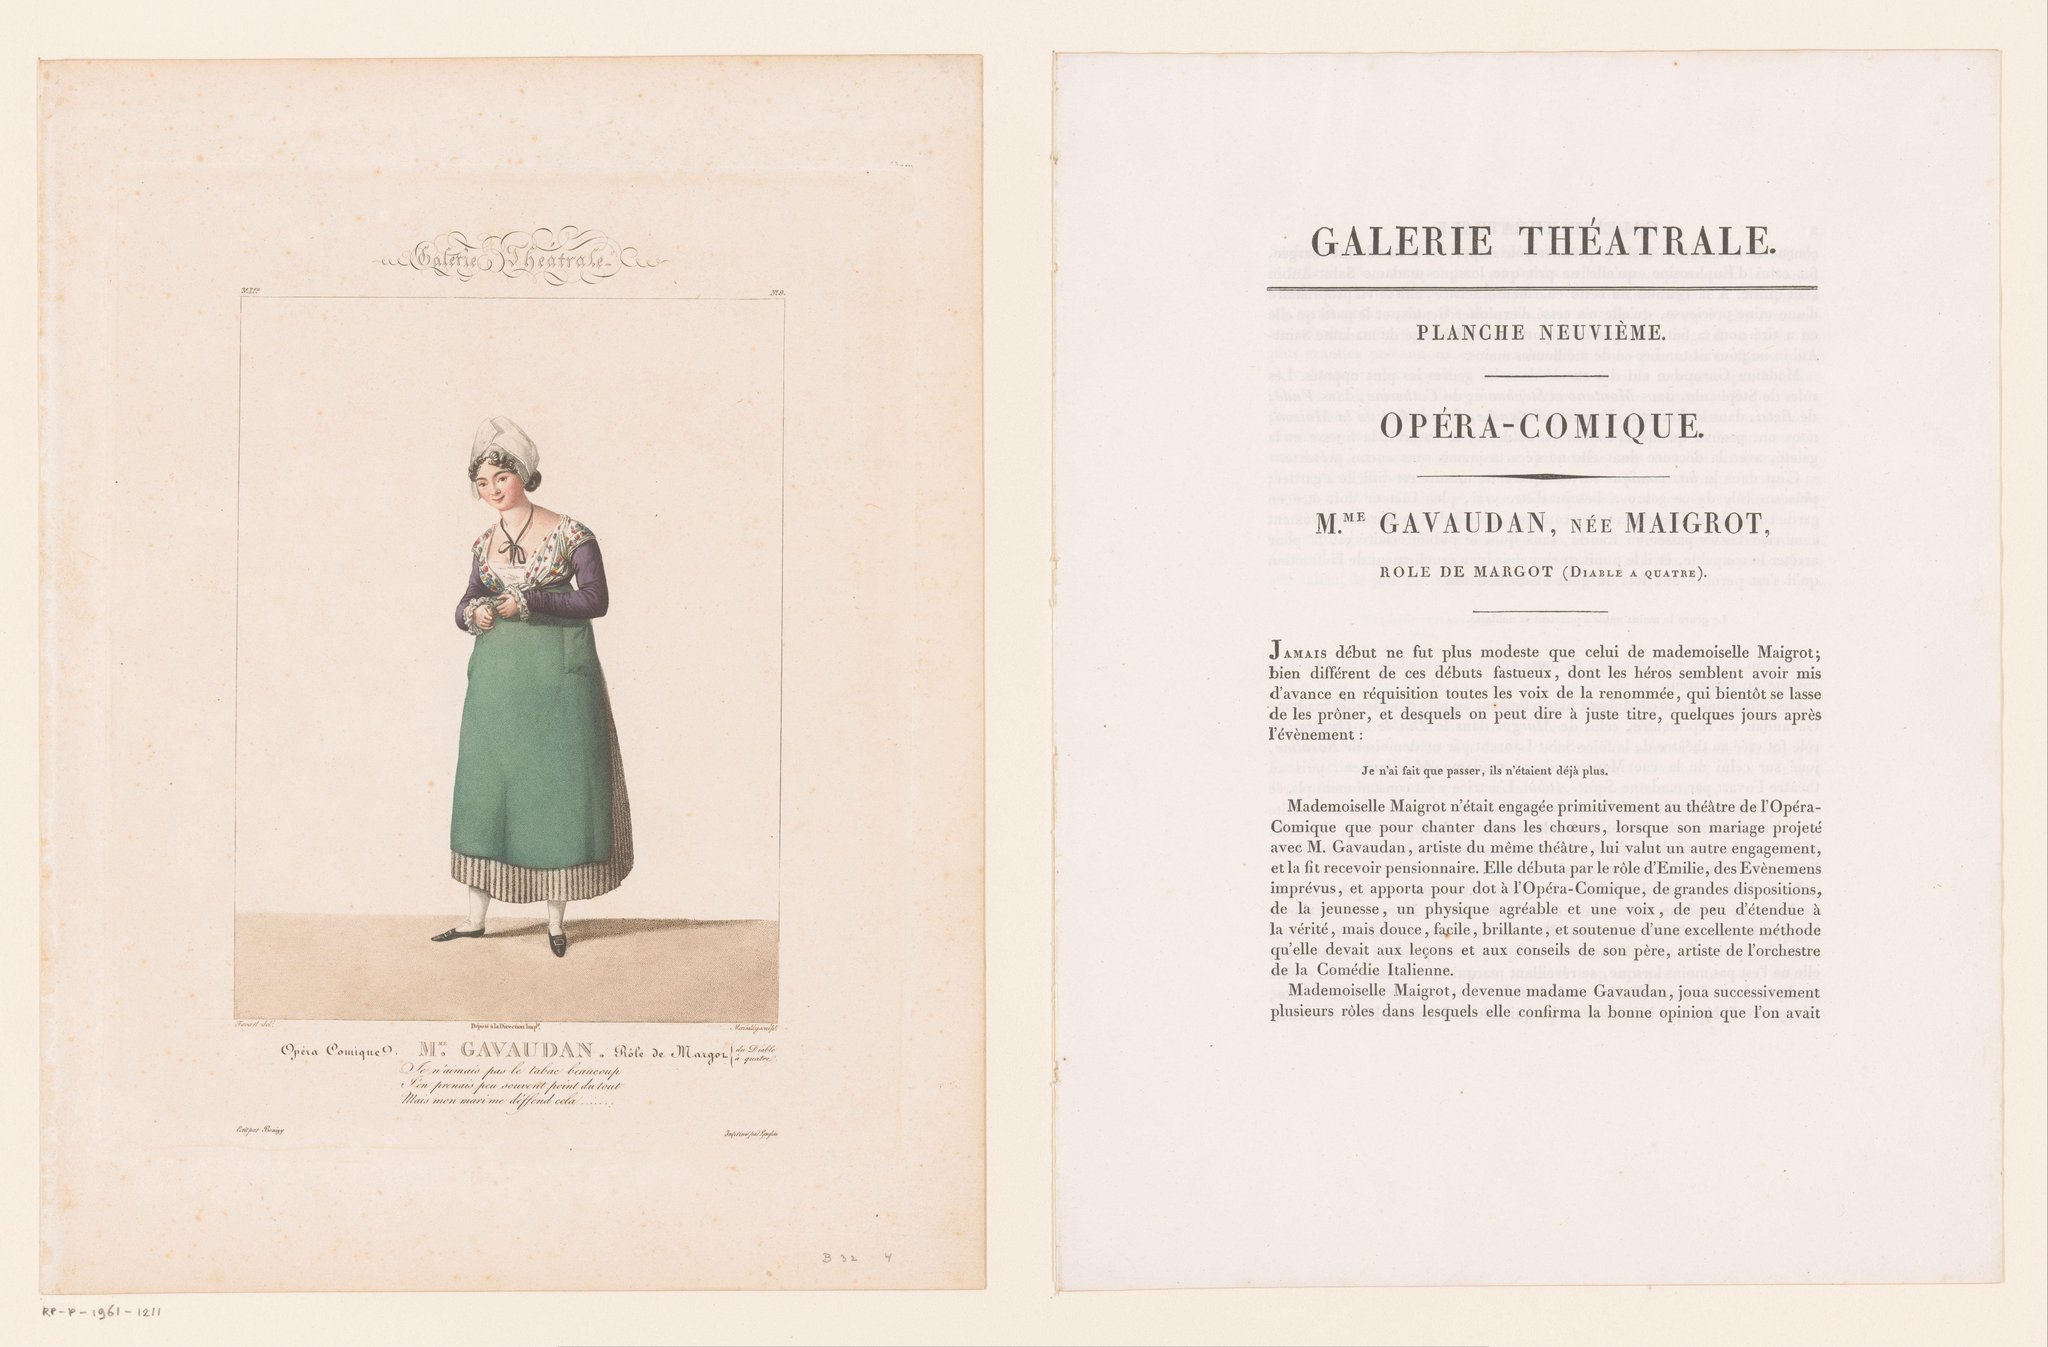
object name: book illustration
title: M.me Gavaudan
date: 1812-1834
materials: paper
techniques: engraving, hand coloring, lithography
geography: paris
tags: historical persons, portrait of actor, actress, portrait of opera-singer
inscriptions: : ‘Déposé à la Direction Imp.le’, collector's mark: Lugt 2228, collector's mark: ‘cirkel met daar omheen de tekst: school voor de grafische vakken te Utrecht’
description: Prent uit: Galerie théâtrale ou collection des portraits en pied des principaux acteurs des premiers théâtres de la capitale. Parijs: Jacques Louis Bance, 1812-1834.